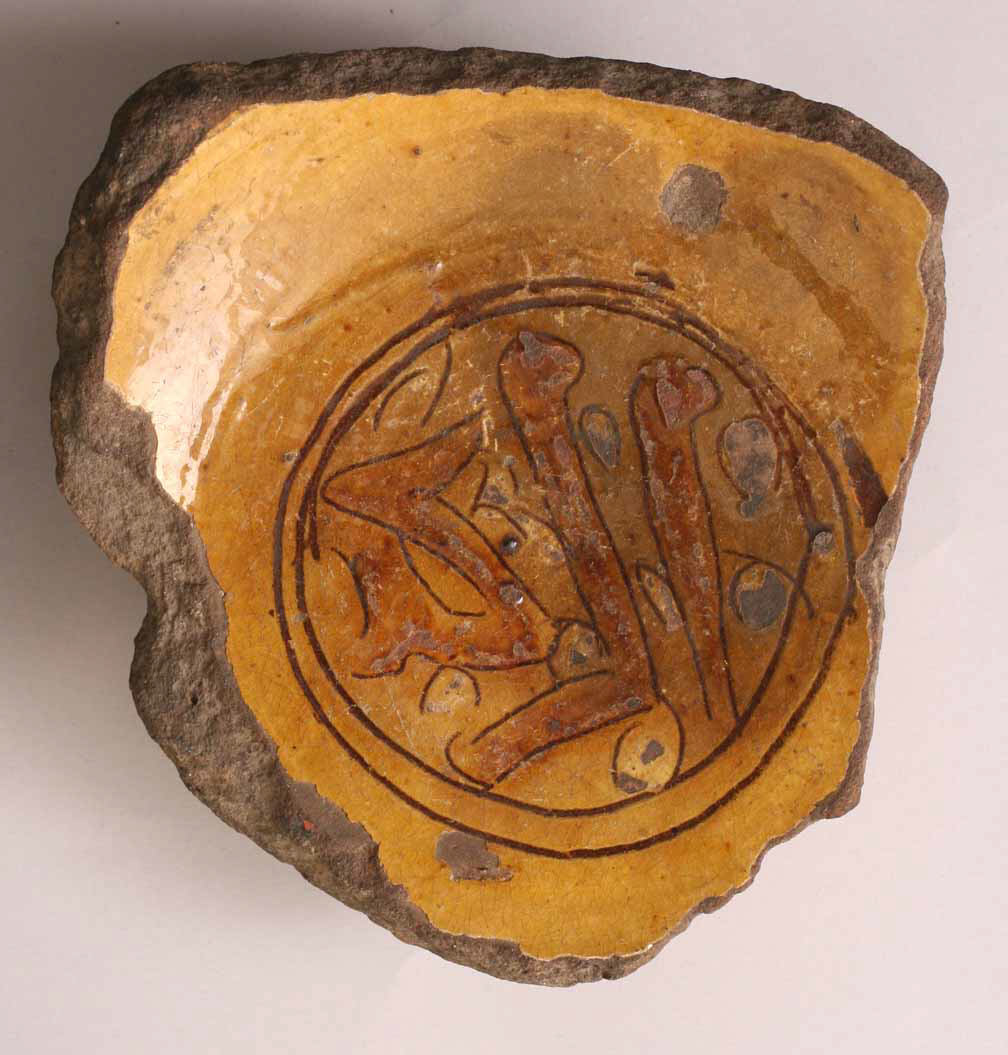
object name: fragment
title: Fragment of a Bowl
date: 1301-1500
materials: earthenware, glaze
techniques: coloring, incising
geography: egypt